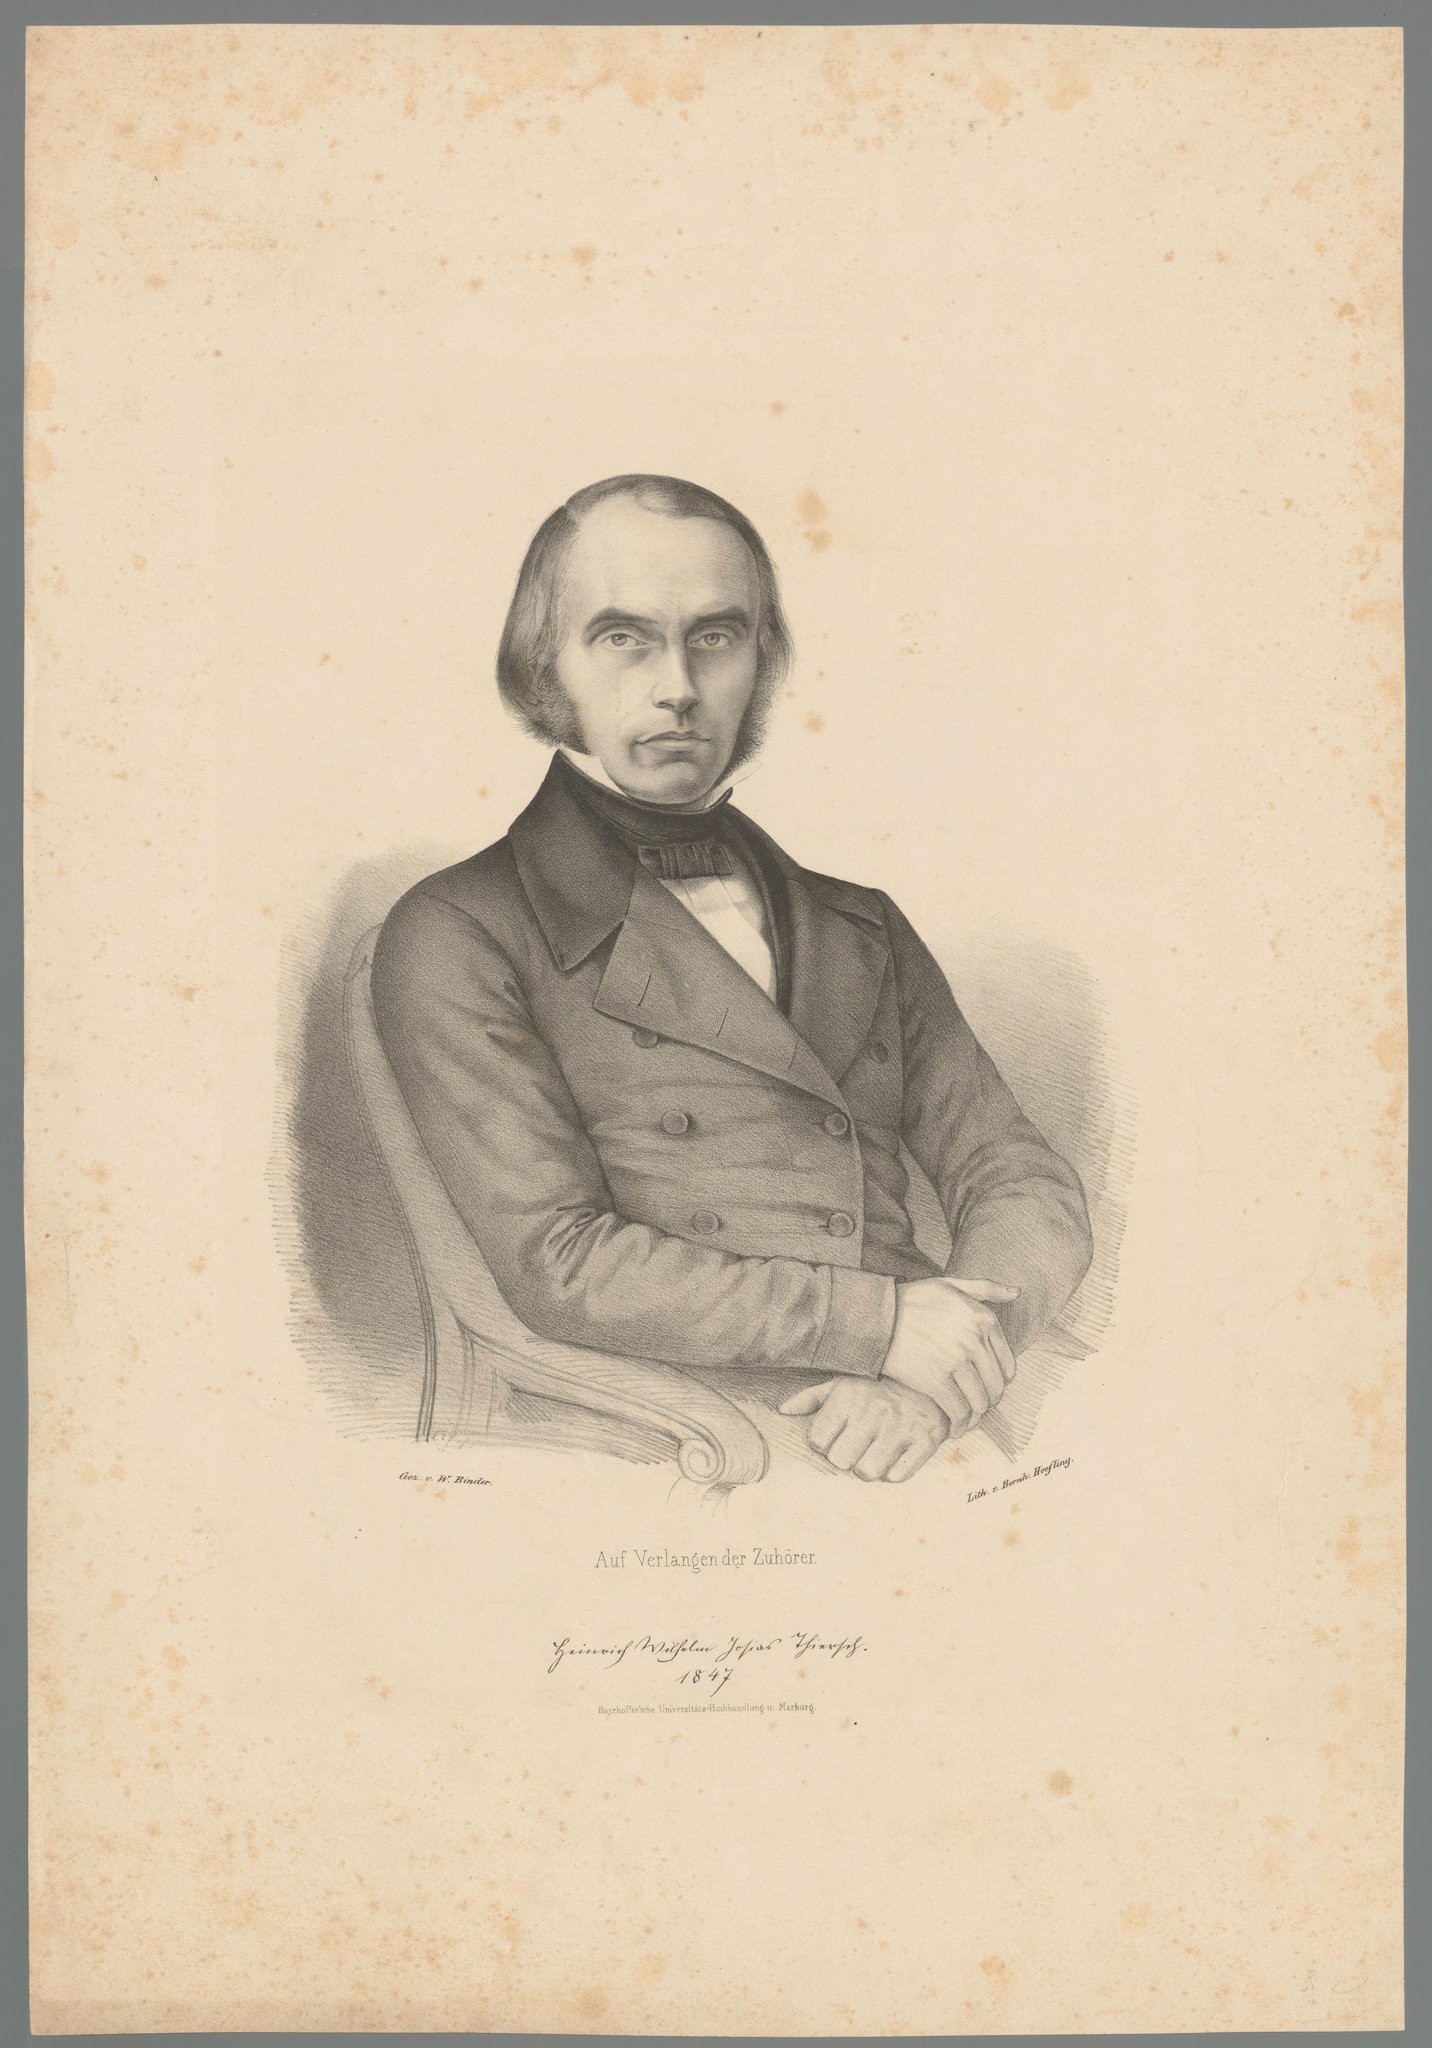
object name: print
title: Auf Verlangen der Zuhörer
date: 1847-1871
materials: paper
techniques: lithograph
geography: marburg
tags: adult man, historical persons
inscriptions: collector's mark: Lugt 2228